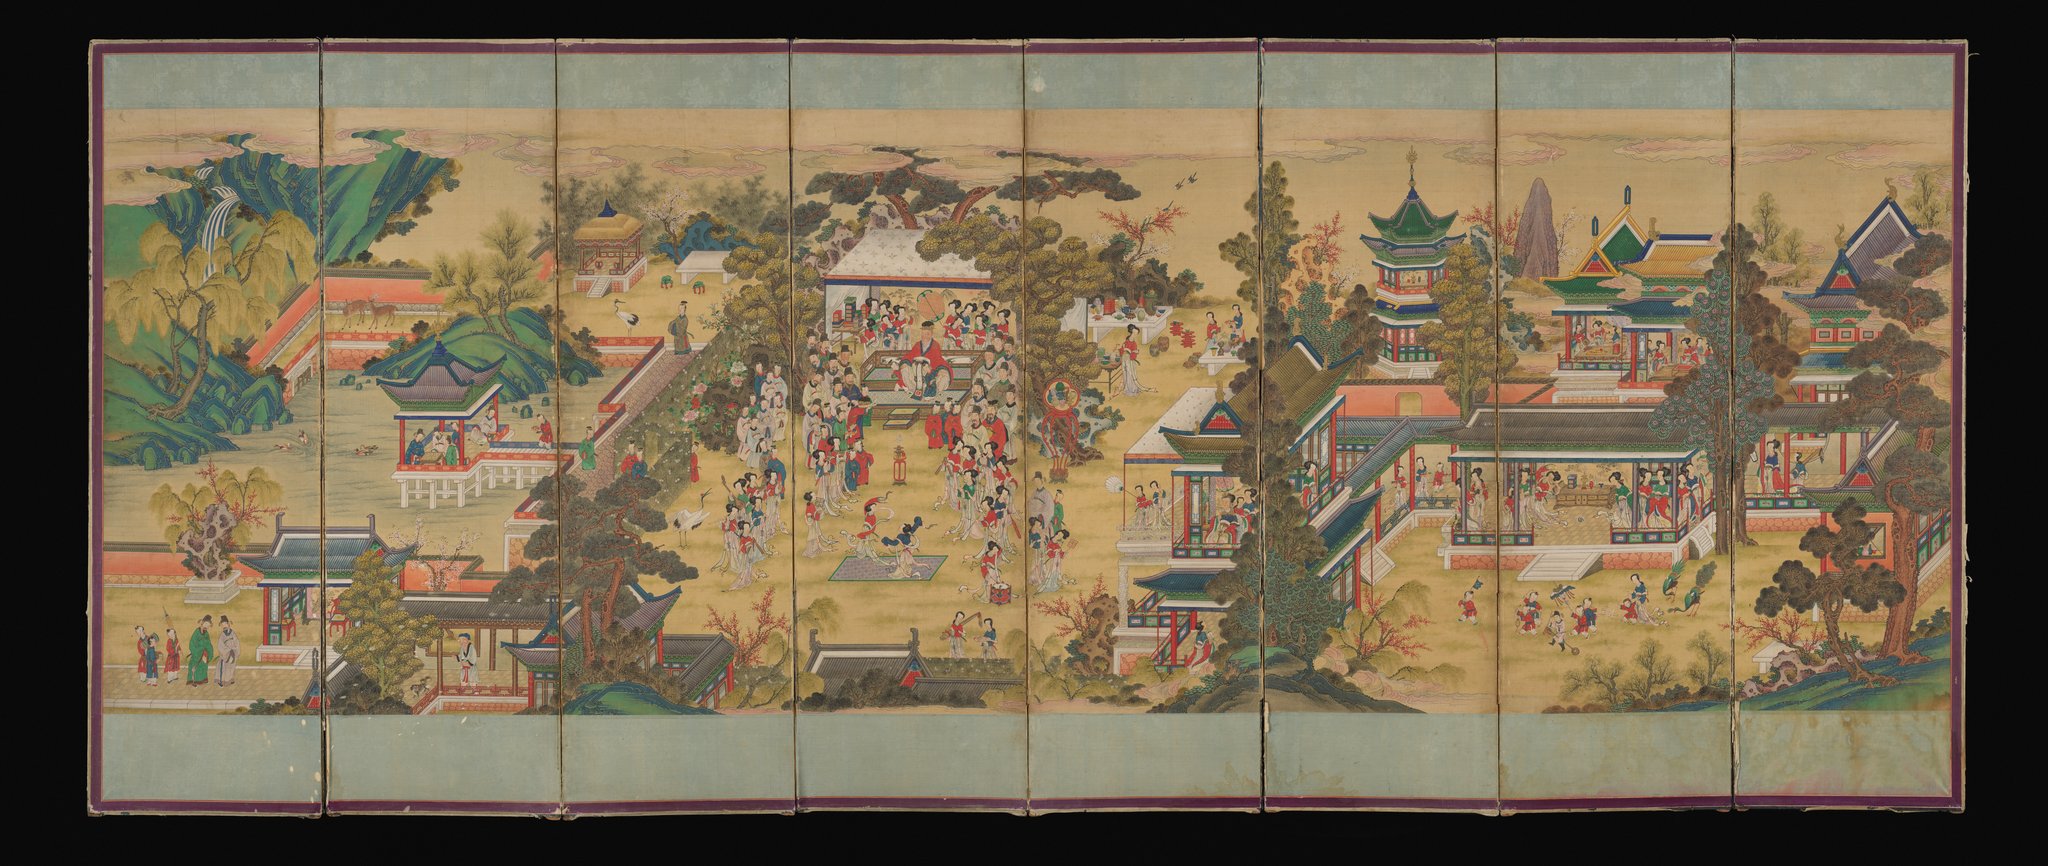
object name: screen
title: The Banquet of Guo Ziyi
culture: korean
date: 1867-1900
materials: ink, panel, silk